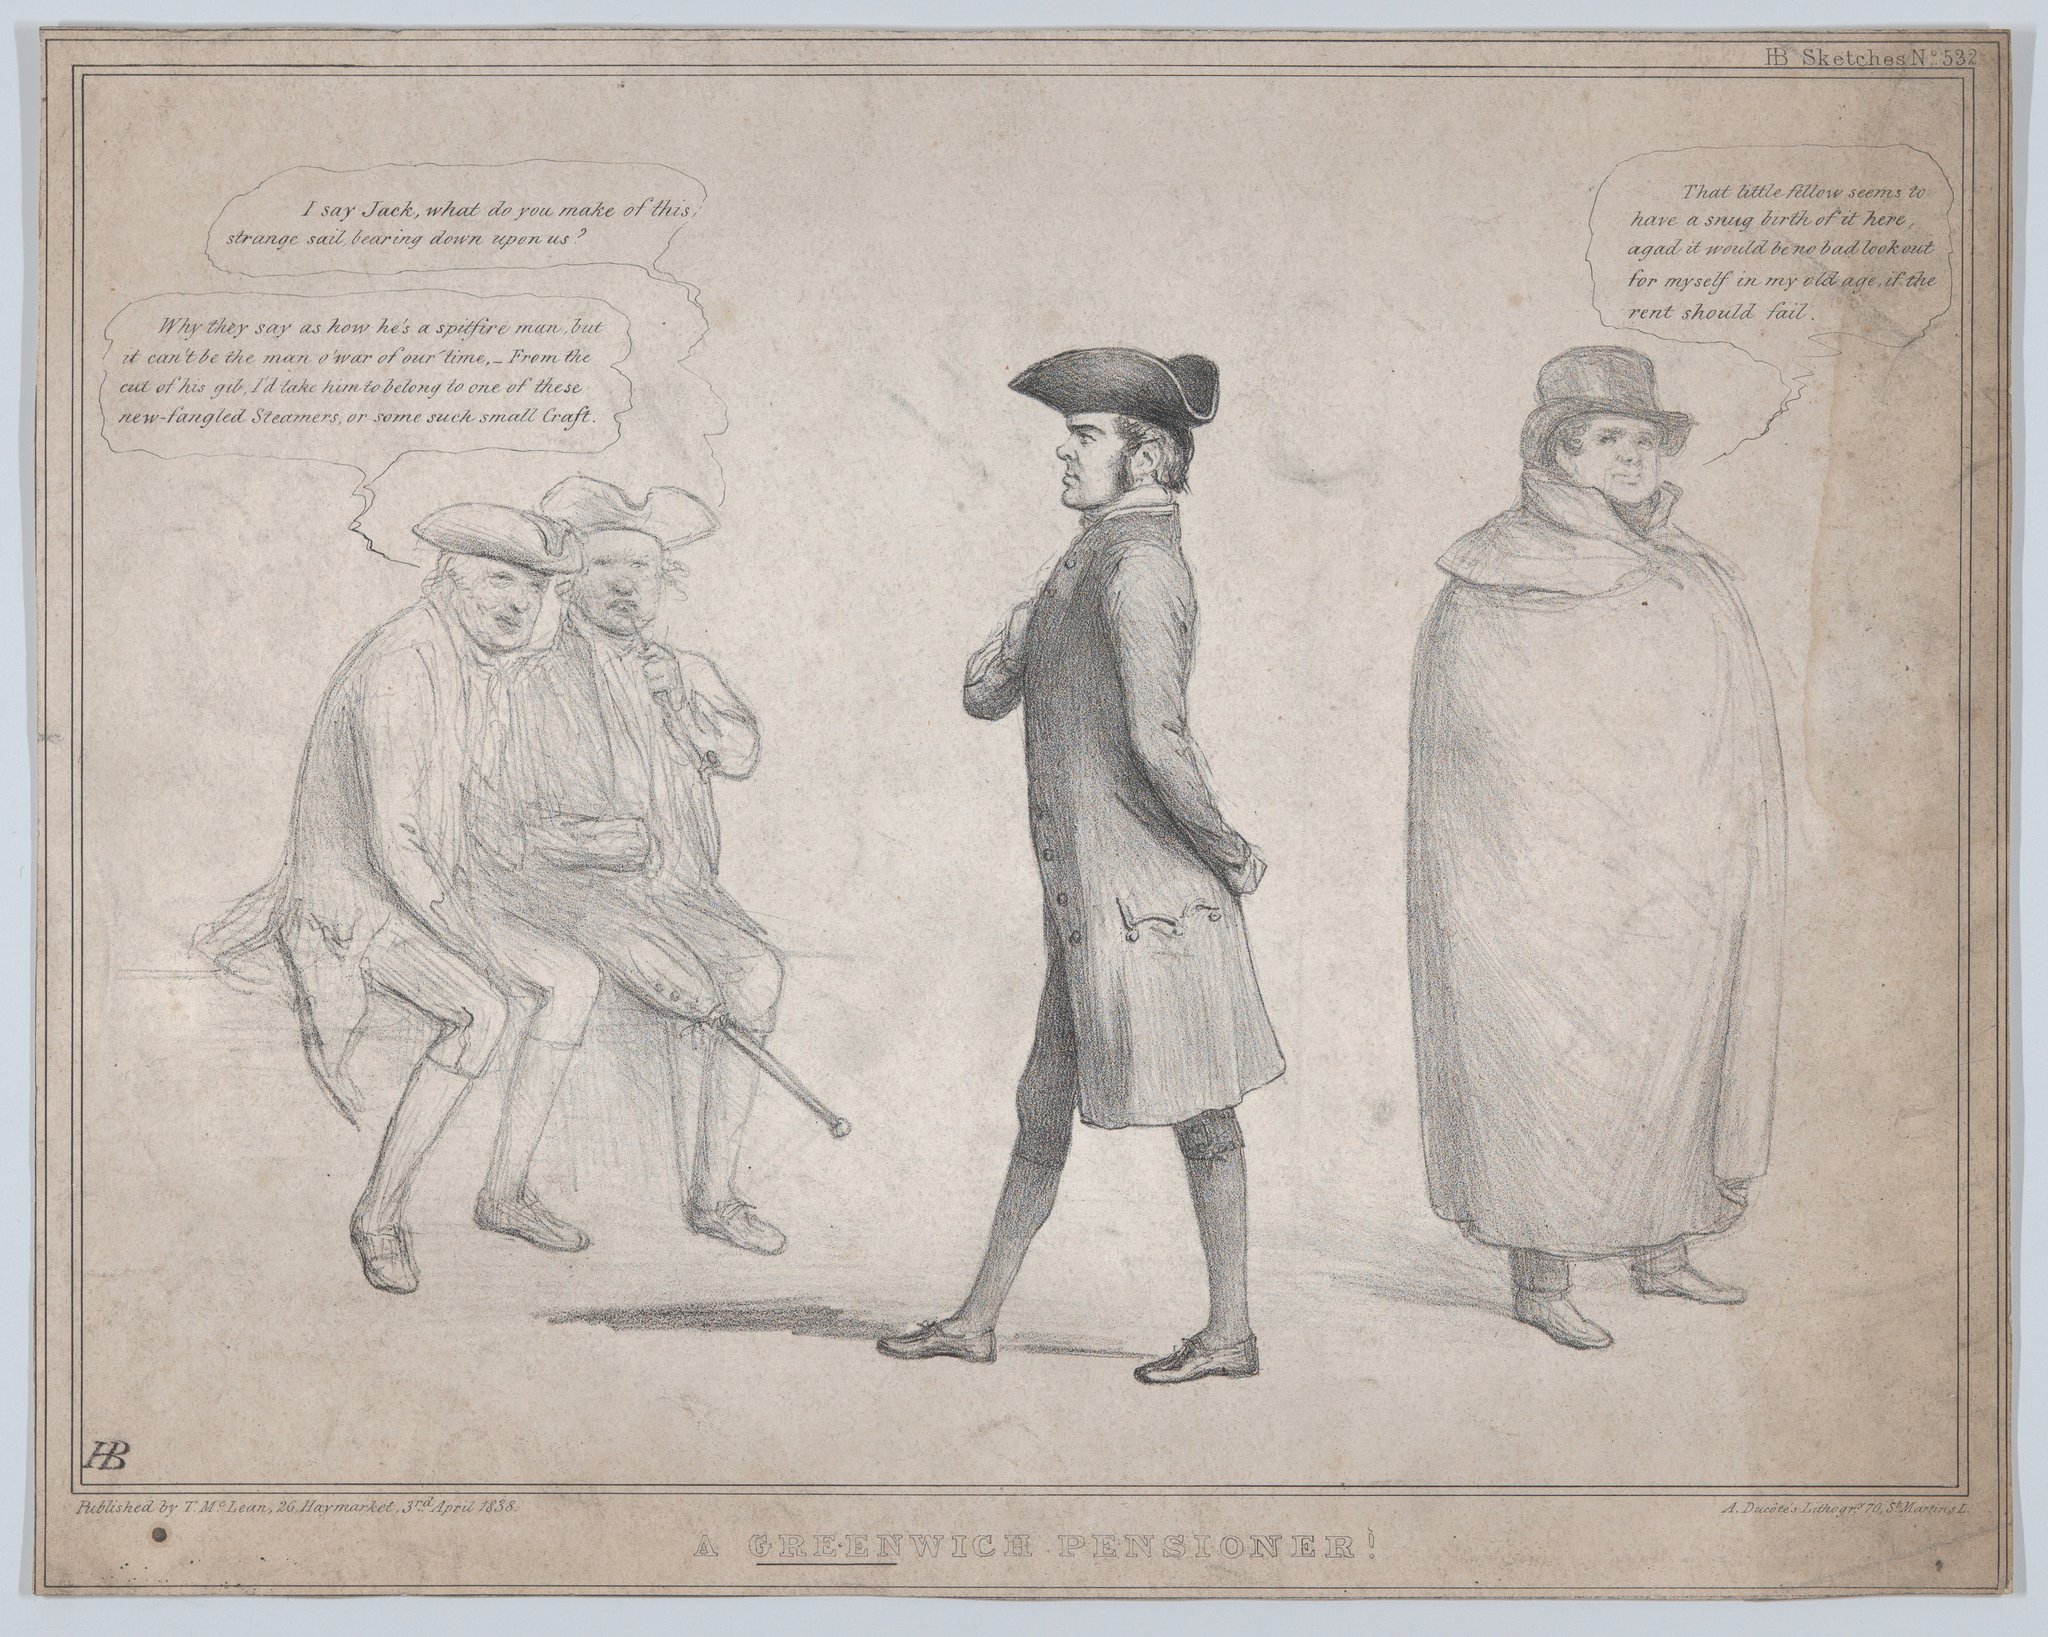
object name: print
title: A Greenwich Pensioner!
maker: john doyle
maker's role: artist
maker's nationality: irish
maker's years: 1797-1868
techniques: lithograph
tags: men